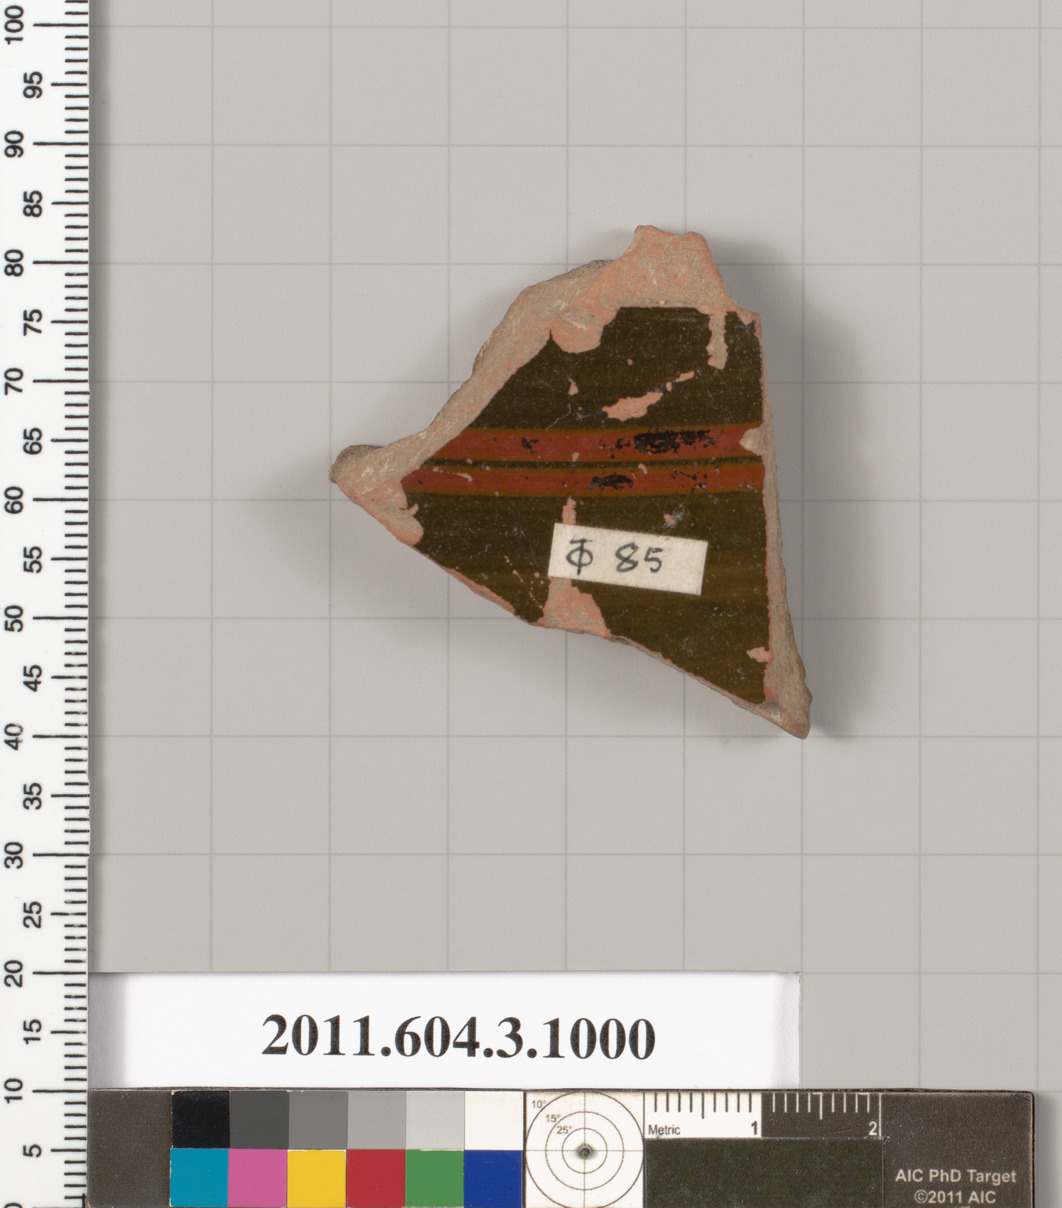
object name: lekanis fragment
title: Terracotta fragment of a lekanis (covered dish)?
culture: greek, attic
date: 600-501 BCE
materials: terracotta